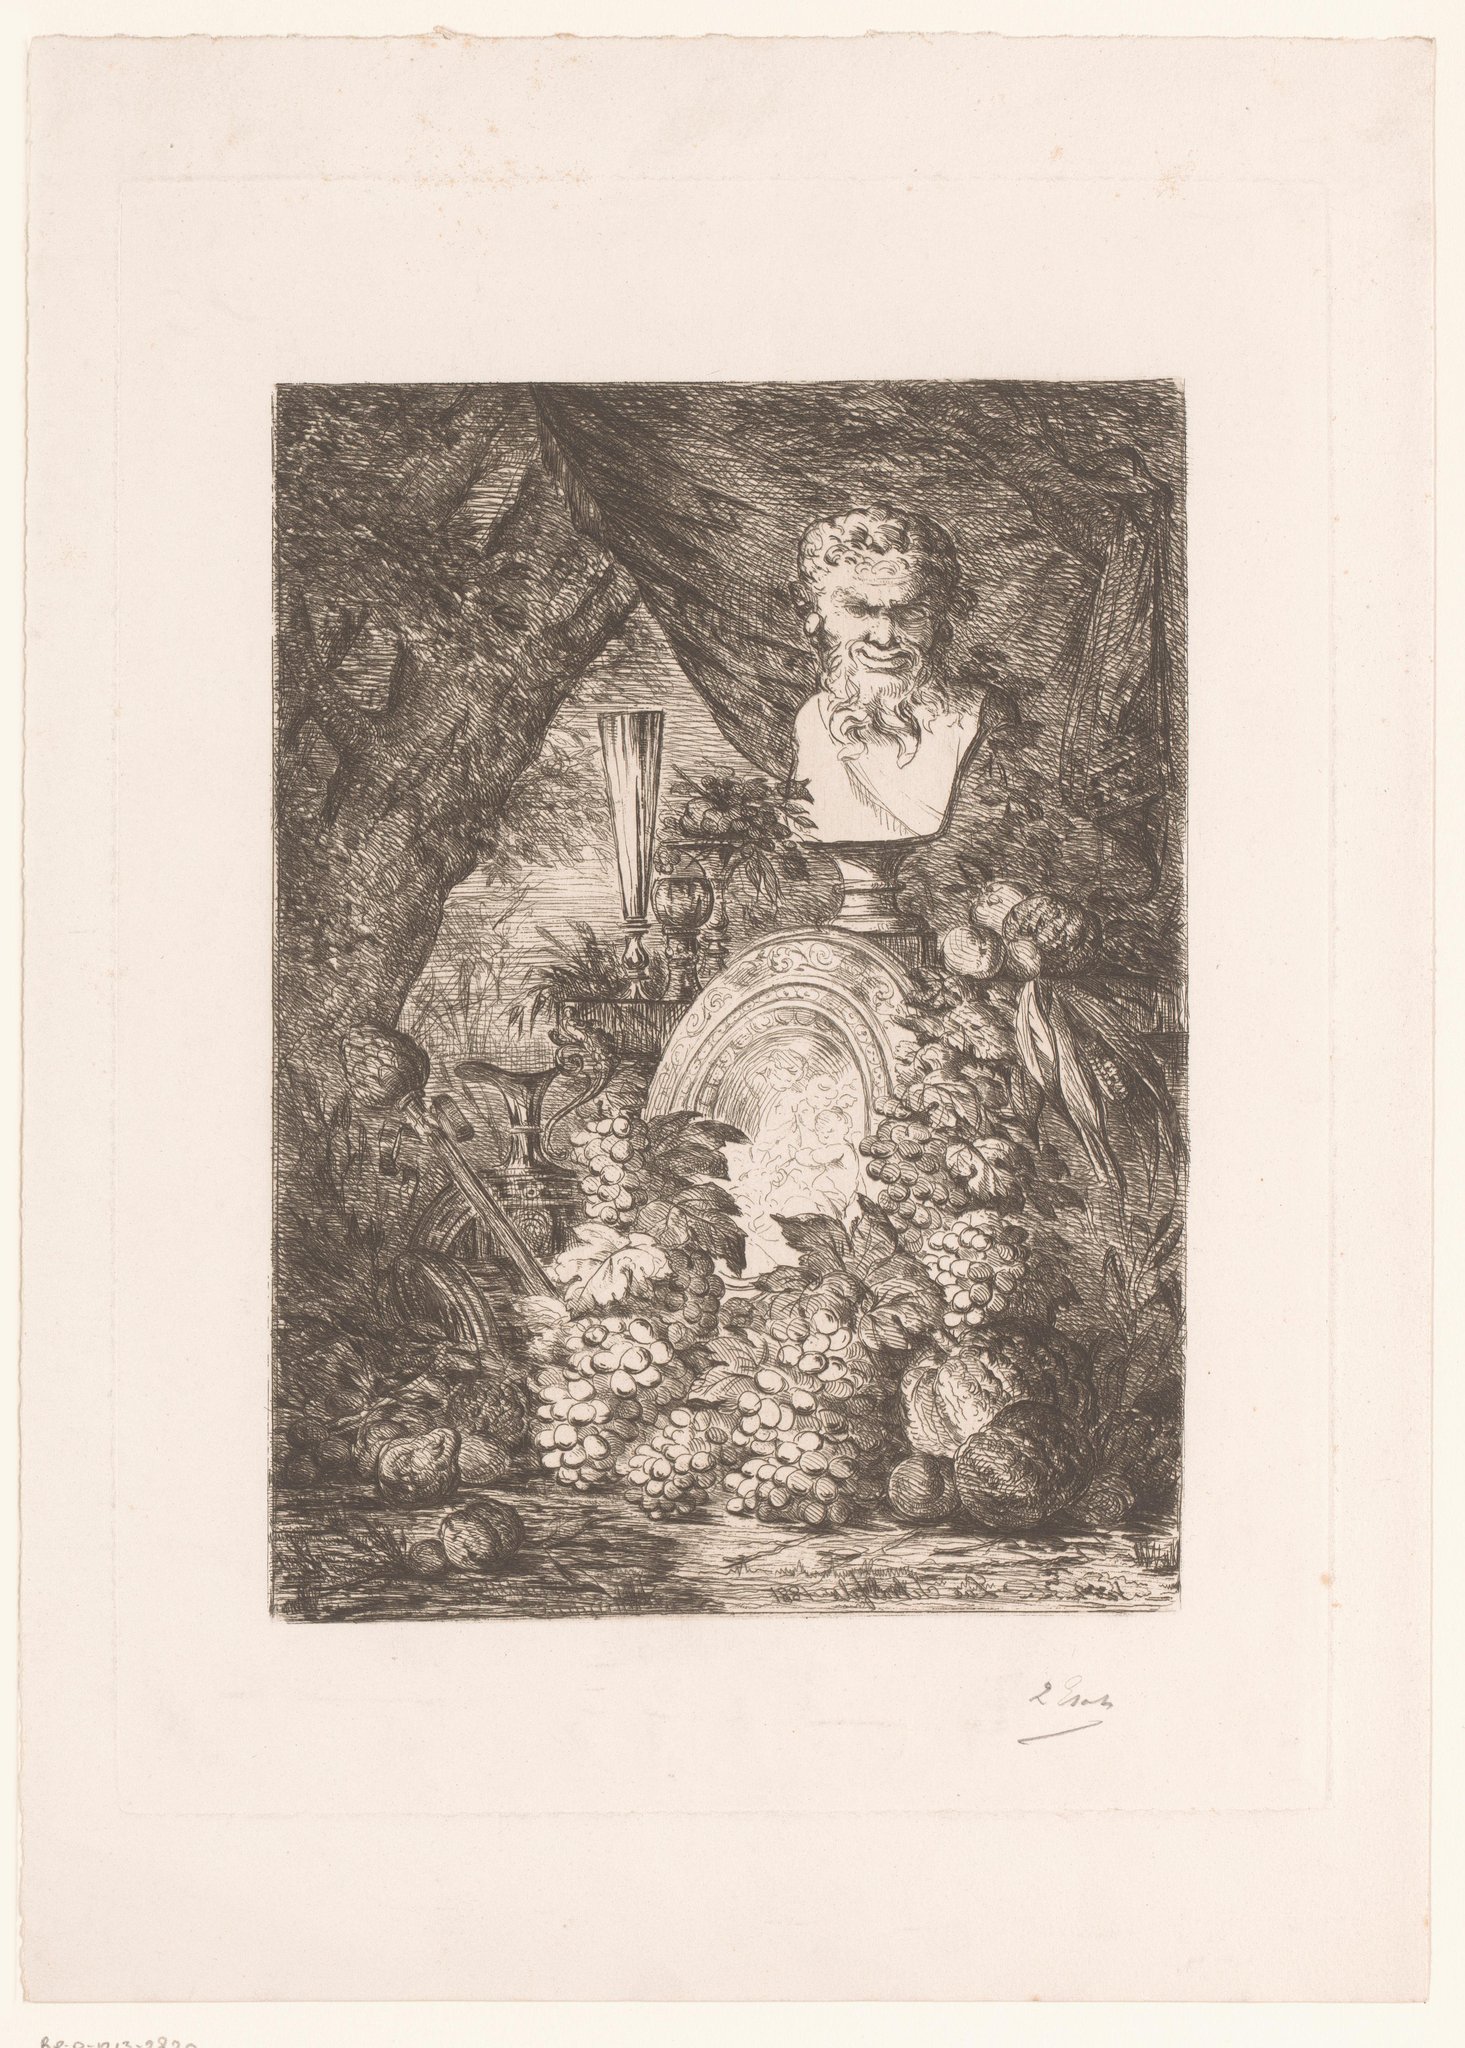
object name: print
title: Stilleven met Bacchus-buste, druiven en vaatwerk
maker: lucas victor schaefels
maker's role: draughtsman, print maker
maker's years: 1824-1885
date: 1881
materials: paper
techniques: etching, retroussage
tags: attributes of bacchus, thyrsus ~ attribute of bacchus, still life of related objects, drinking-vessels, bunch of grapes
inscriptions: inscription: ‘2 etat’, collector's mark: Lugt 2228